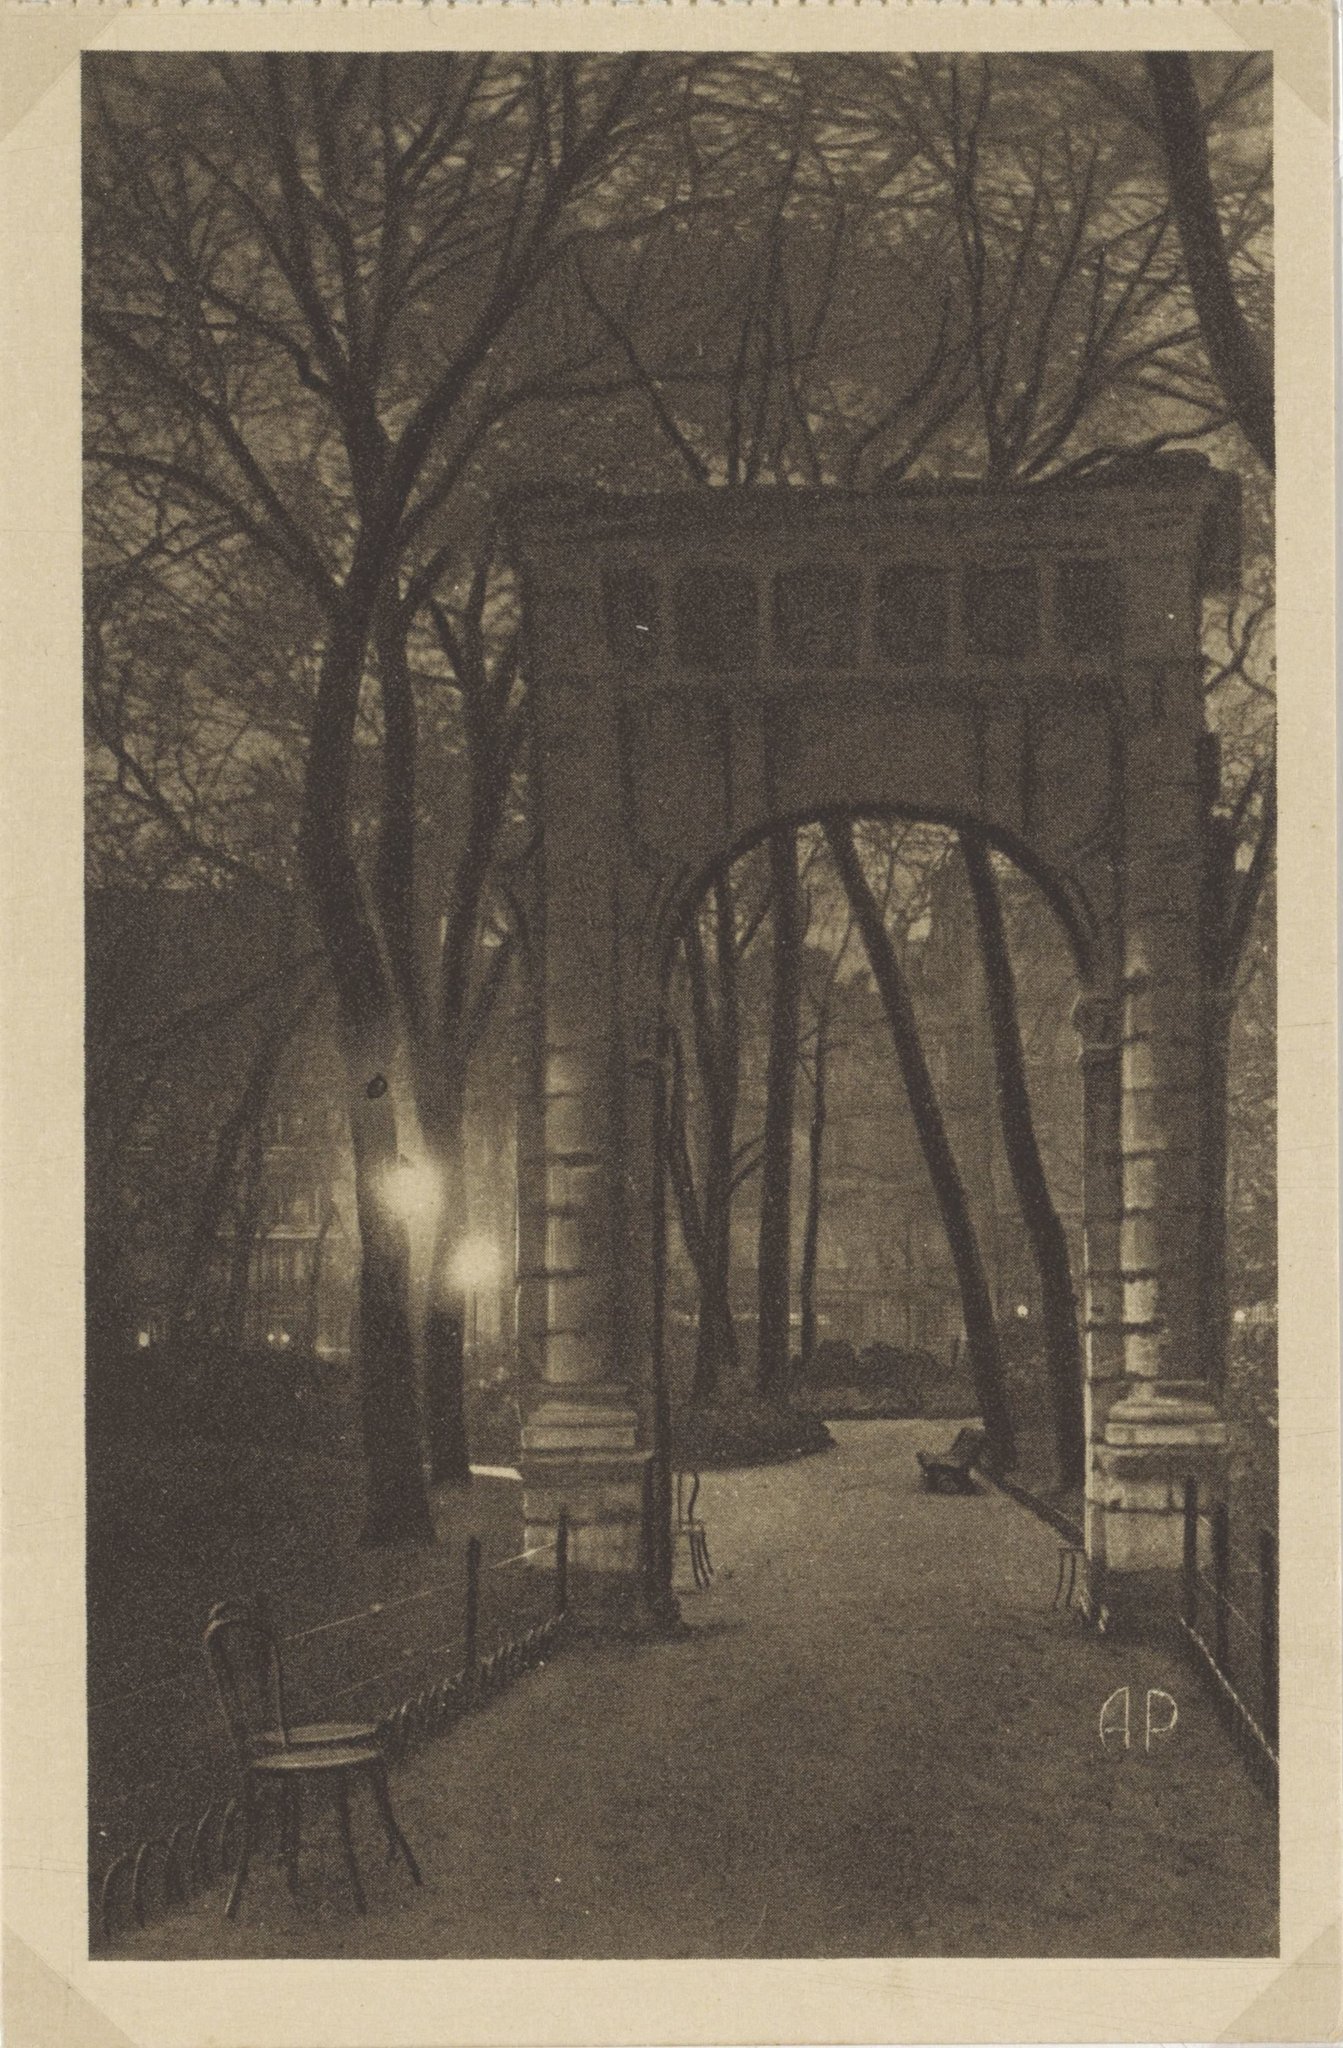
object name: photograph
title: Poort in Parc Monceau in Parijs bij nacht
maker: Anonymous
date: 1900-1925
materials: cardboard, paper, photographic support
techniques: rotogravure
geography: paris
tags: public gardens, park (+ city(-scape) with figures, staffage)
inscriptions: inscription: ‘Établ. E. Papeghin, 24, Rue des Petites Écuries, Paris’, inscription: ‘AP’